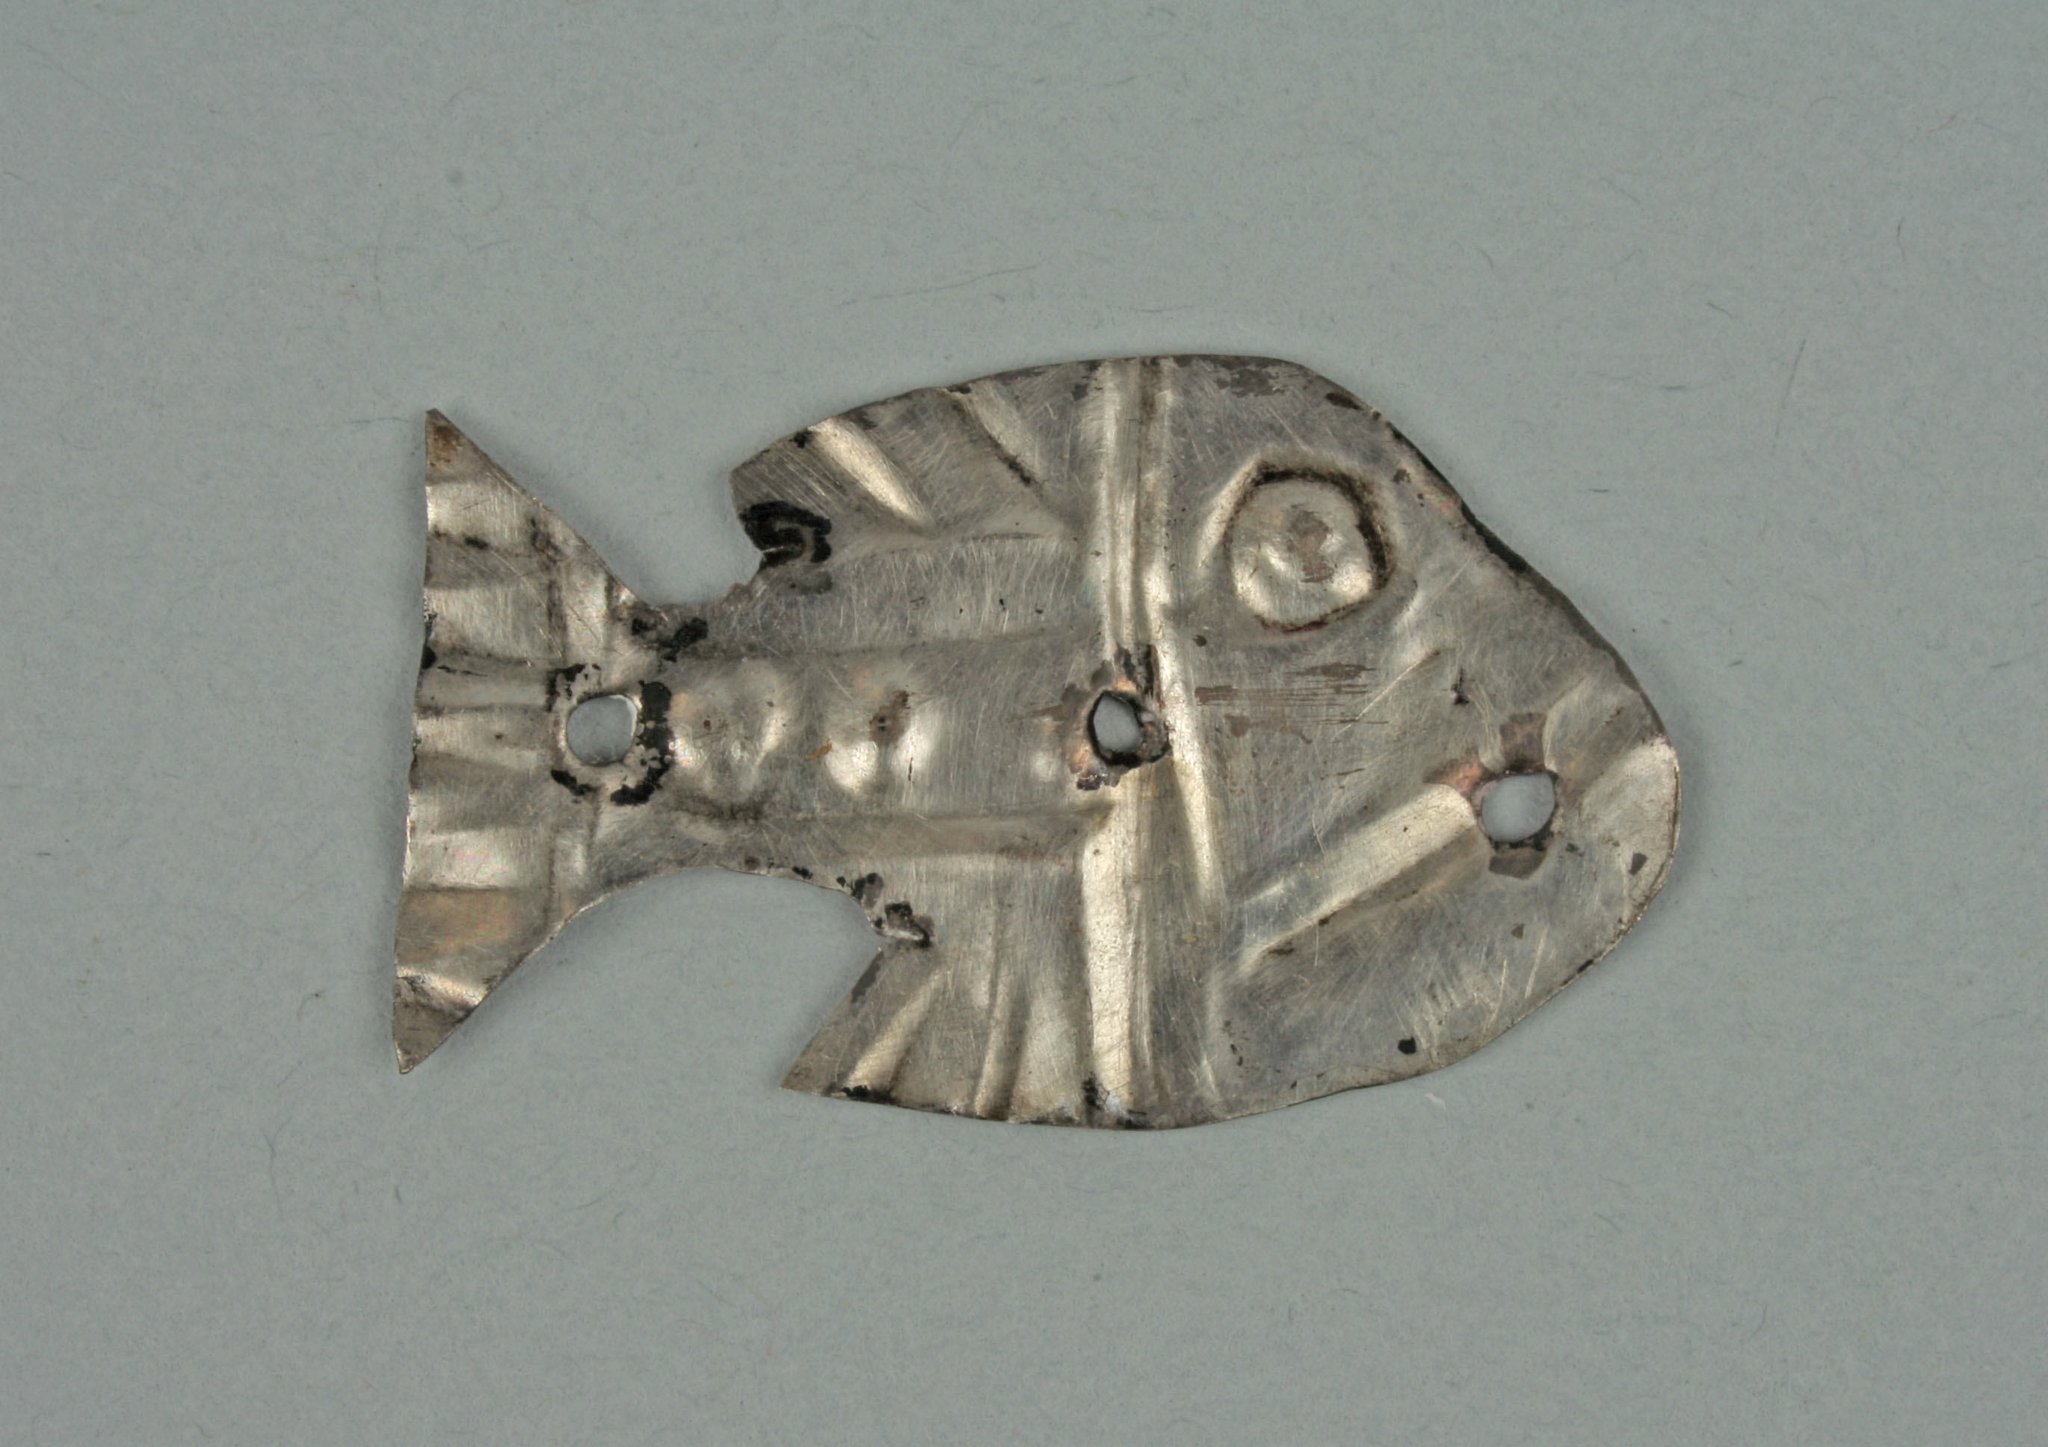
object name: ornament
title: Costume Ornament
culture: chimú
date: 1301-1500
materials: silver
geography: peru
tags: fish